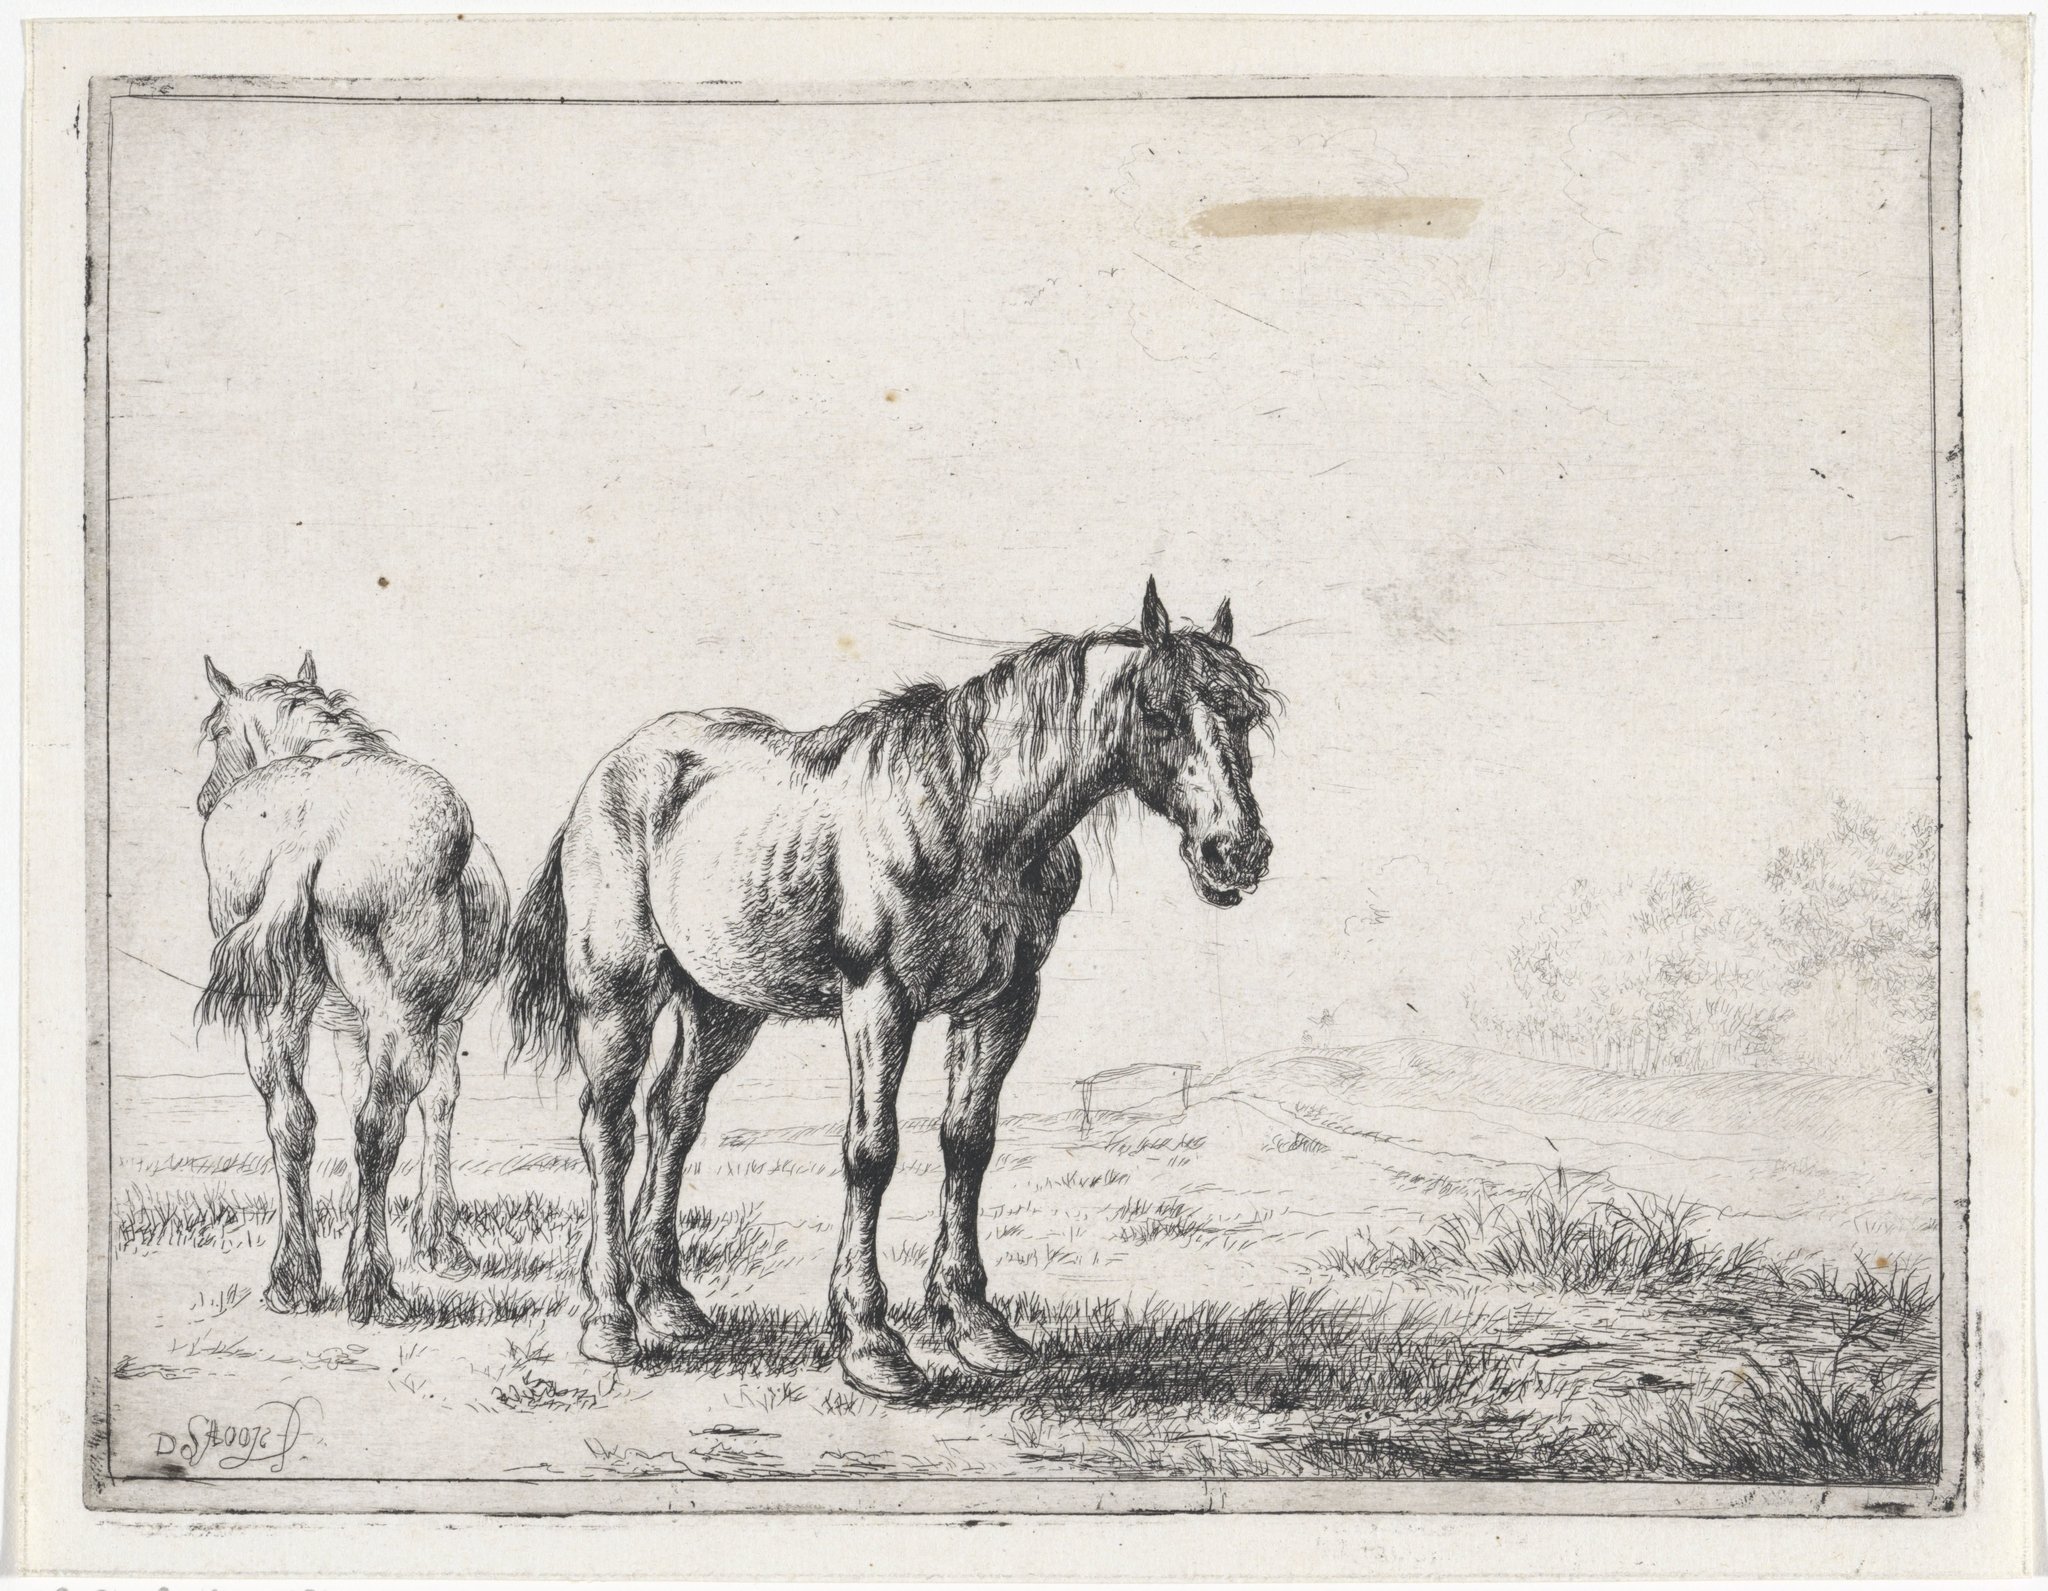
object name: print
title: Paarden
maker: dirk stoop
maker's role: draughtsman, painter, print maker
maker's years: 1615-1686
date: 1651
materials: paper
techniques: etching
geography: utrecht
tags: horse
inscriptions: collector's mark: Lugt 240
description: Twee paarden in een landschap. Het paard link van achteren gezien.